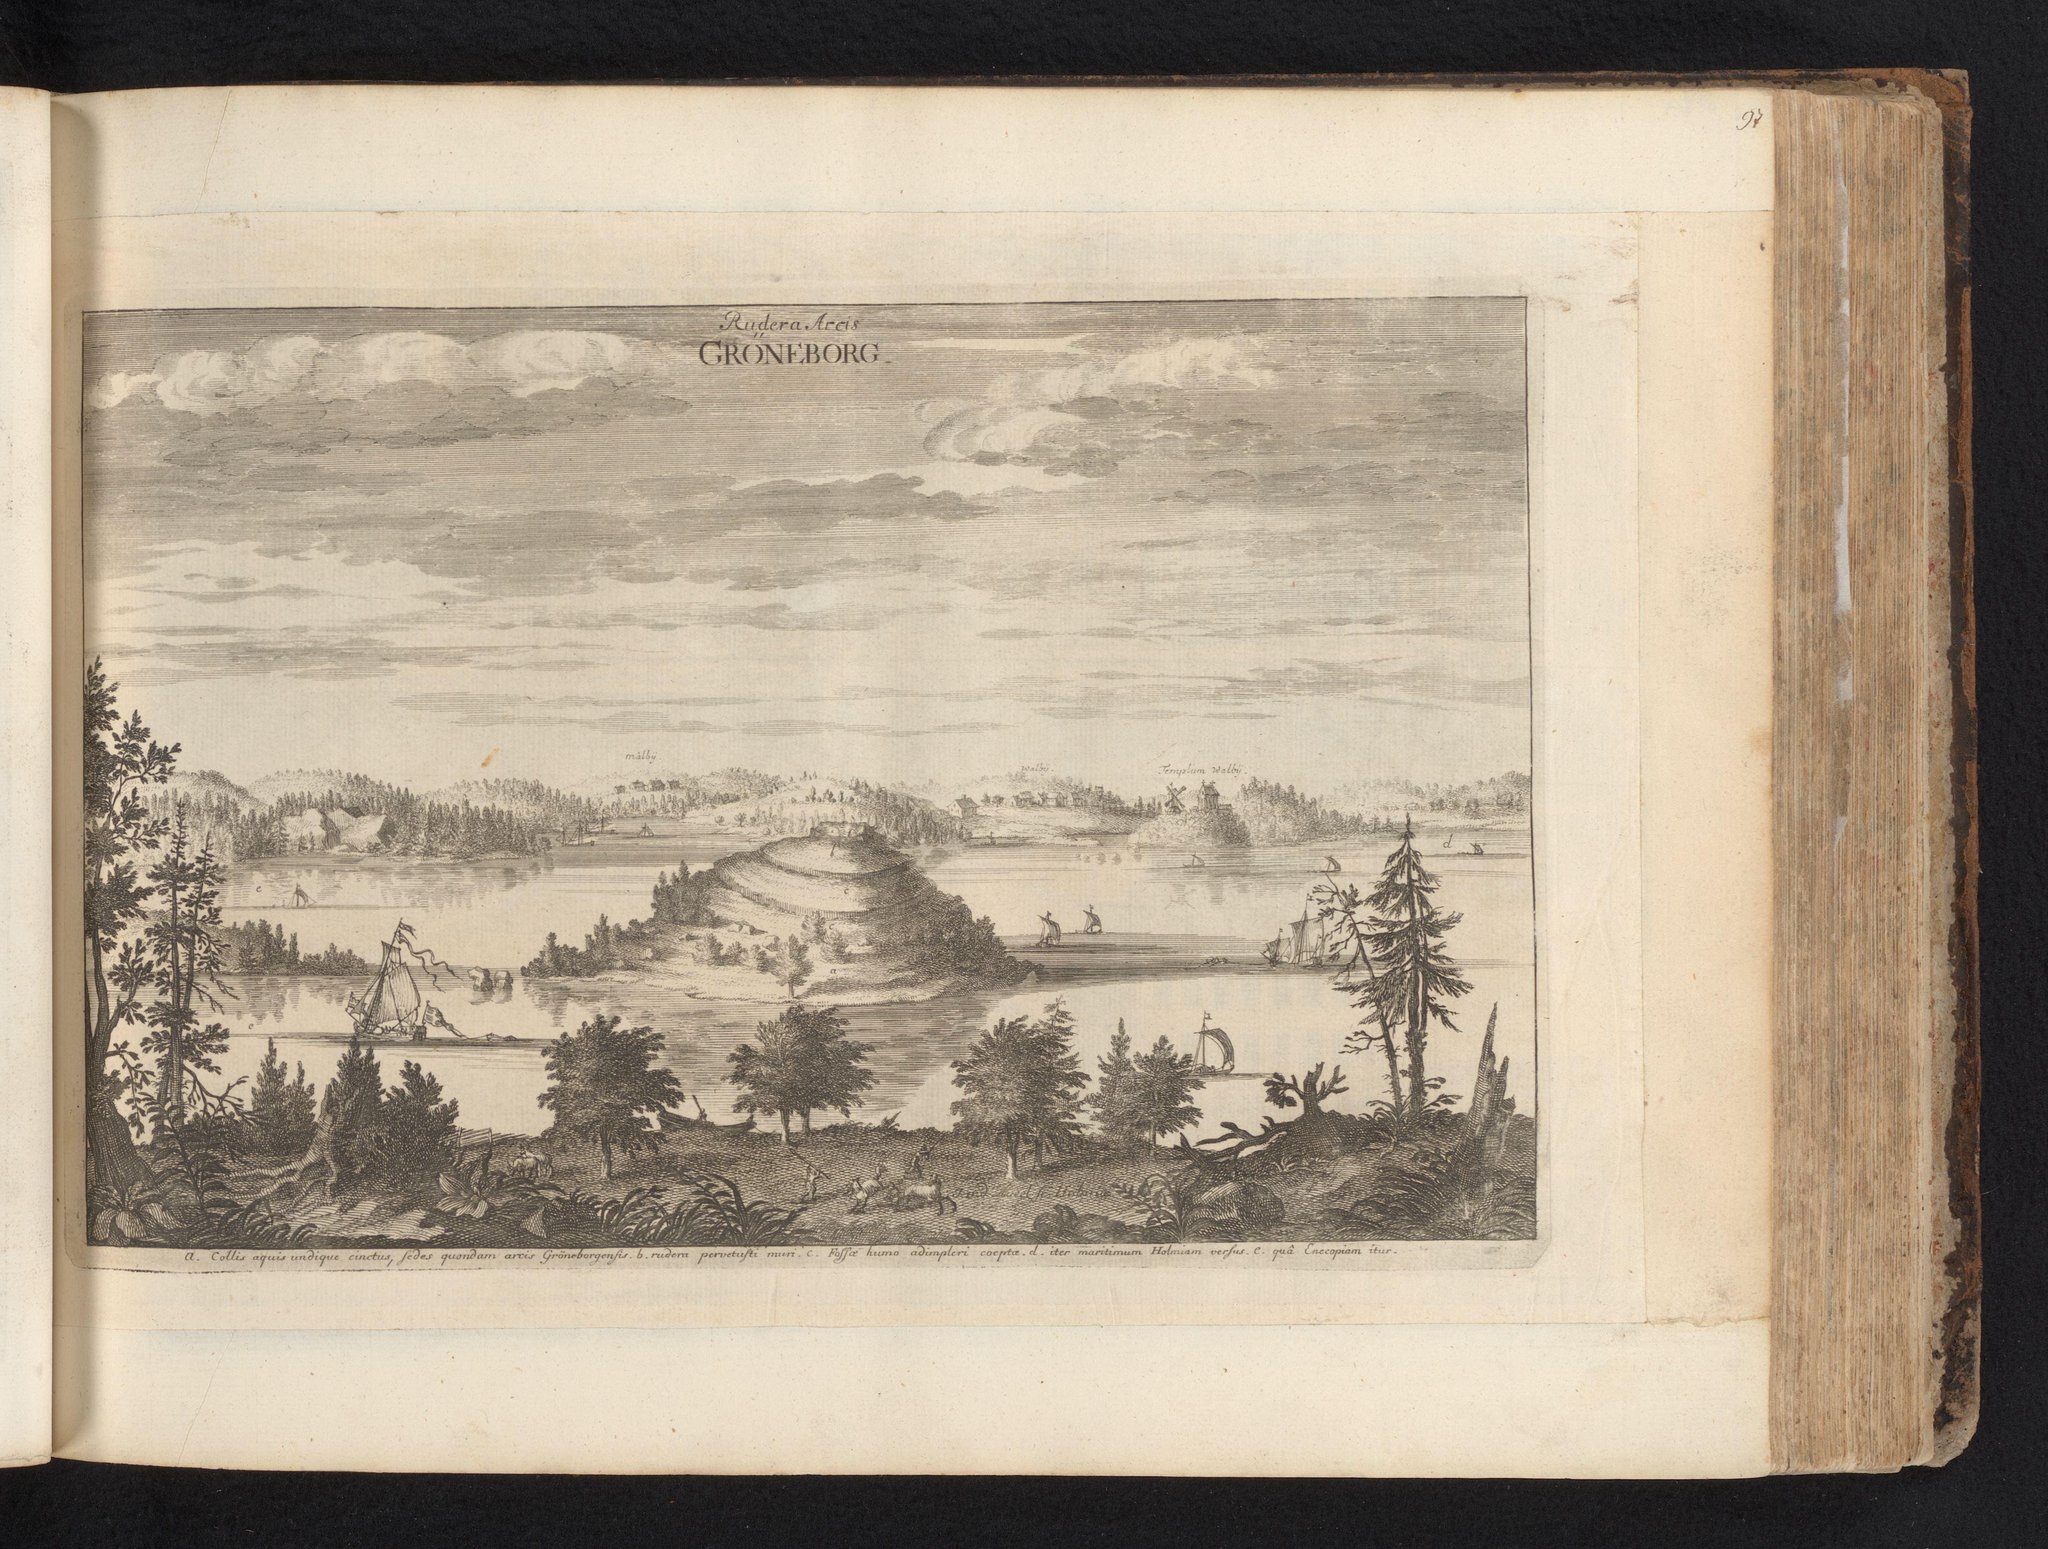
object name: album leaf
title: Rudera Arcis Gröneborg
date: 1709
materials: paper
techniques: etching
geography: stockholm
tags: landscape with ruins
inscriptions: date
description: Kungliga Biblioteket, 'Suecia': http://www.kb.se/samlingarna/Kartor-bilder/Suecia-antiqua/ (geraadpleegd november 2016).